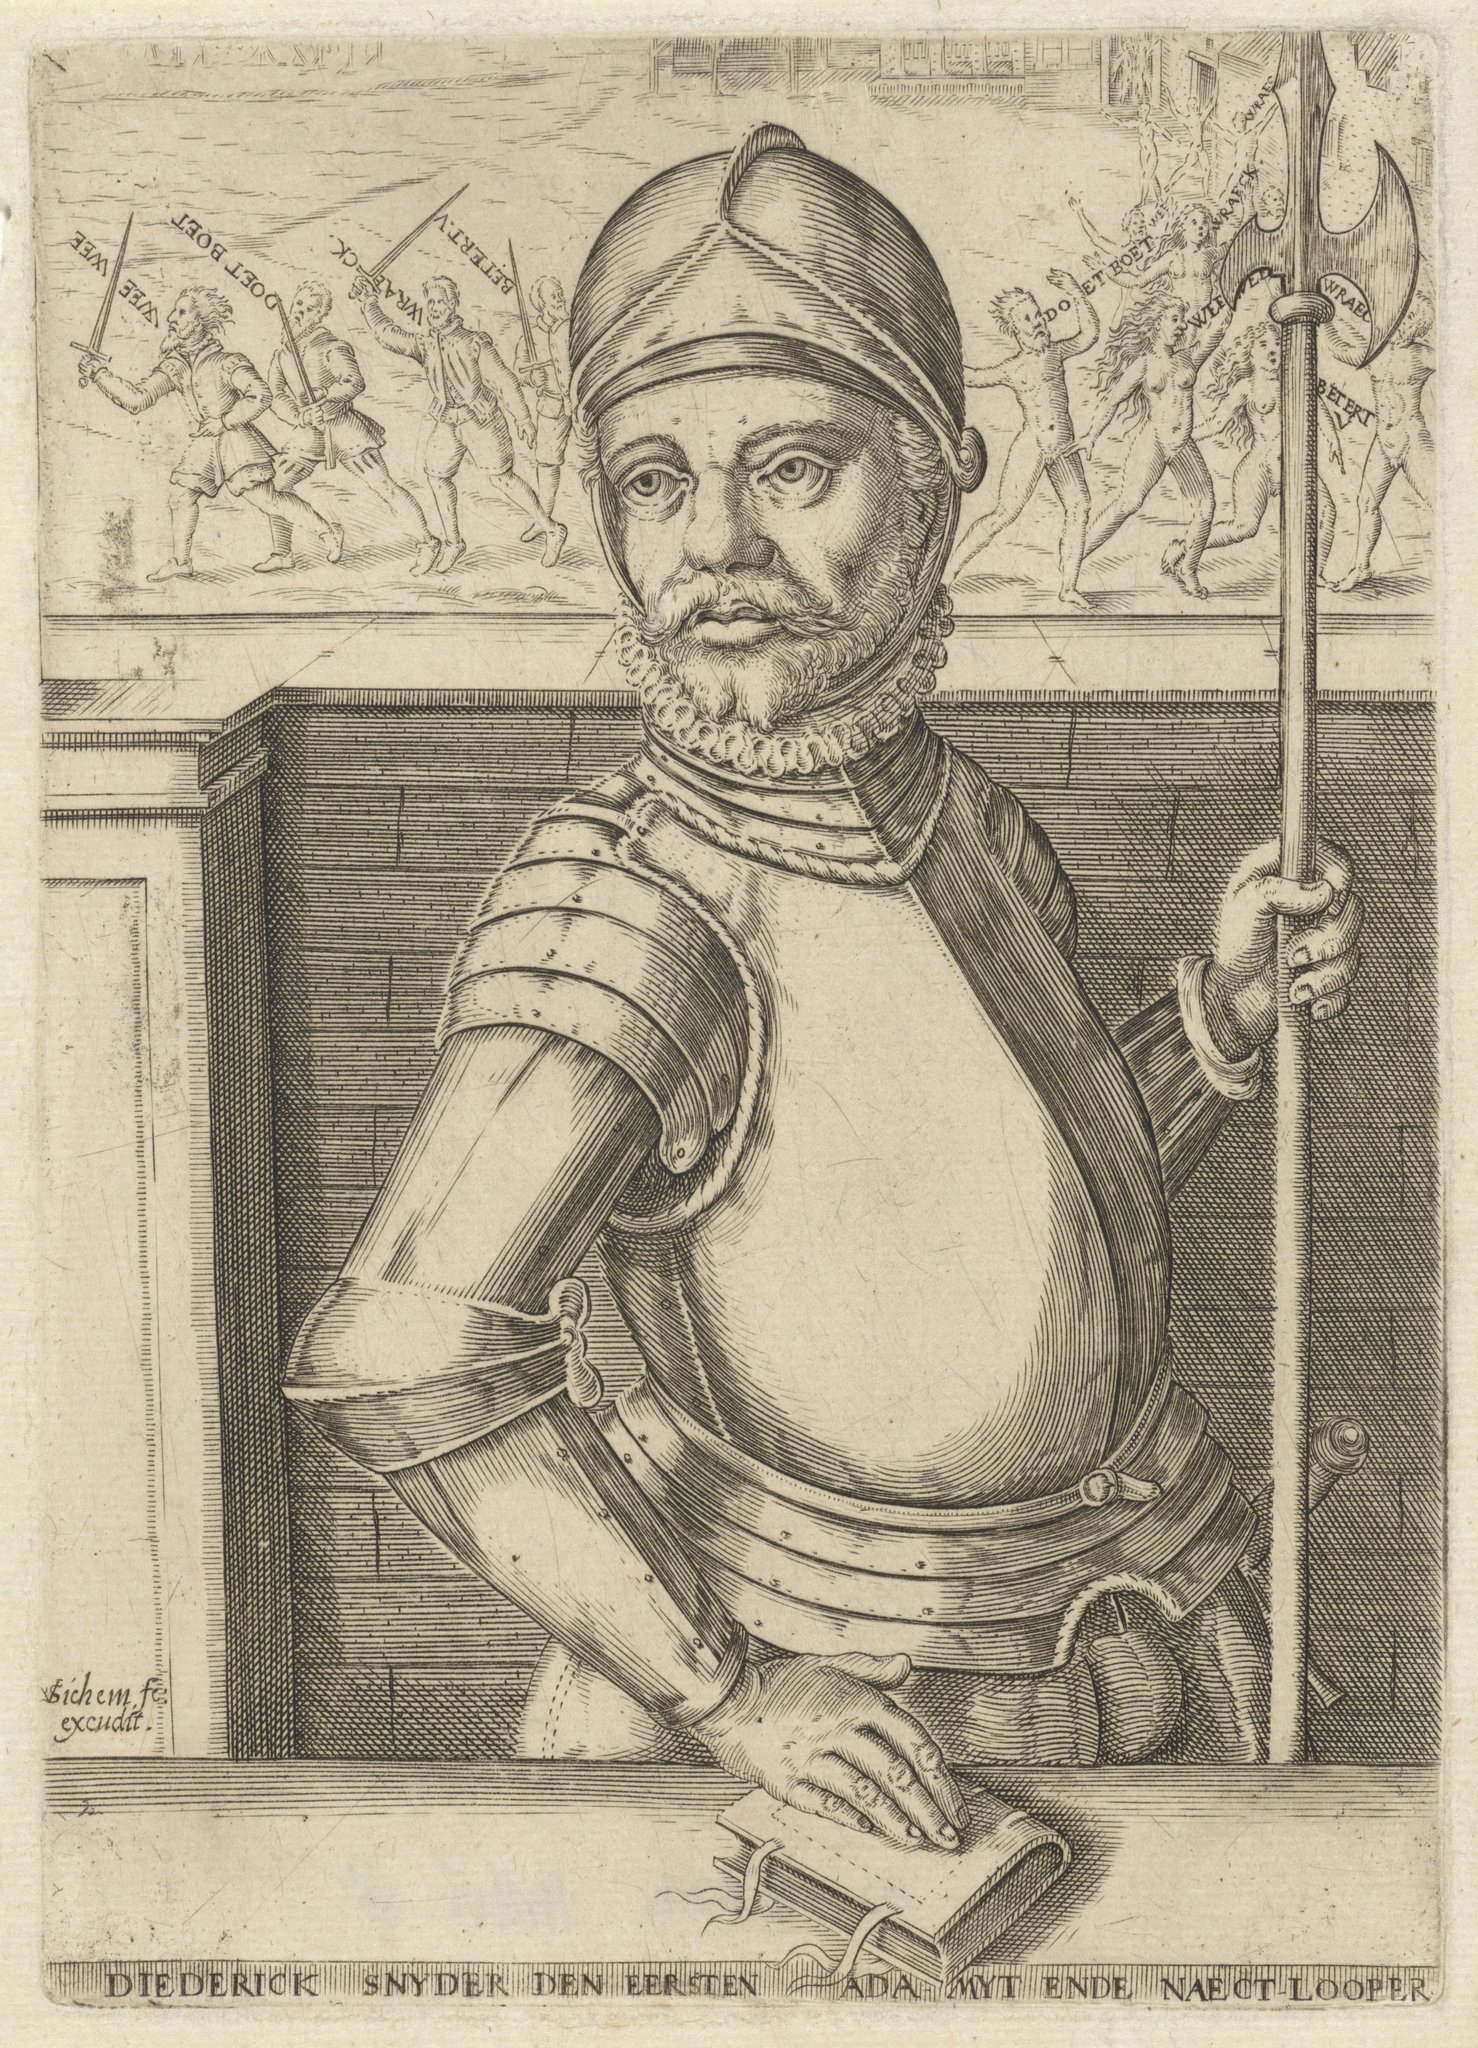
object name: book illustration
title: Portret van Diederick Snyder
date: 1677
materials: paper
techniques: engraving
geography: middelburg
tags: historical persons, amsterdam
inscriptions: collector's mark: Lugt 2228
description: Portret van Diederick Snyder, de leider van een groep van twaalf Wederdopers die in 1535 naakt door Amsterdam liep, biddend en onheil verkondigend. Hij draagt een harnas en houdt een hellebaard vast. Zijn andere hand rust op een boek met sluitlinten. Op de achtergrond is afgebeeld hoe de mannen en vrouwen schreeuwend en naakt door de straten lopen.